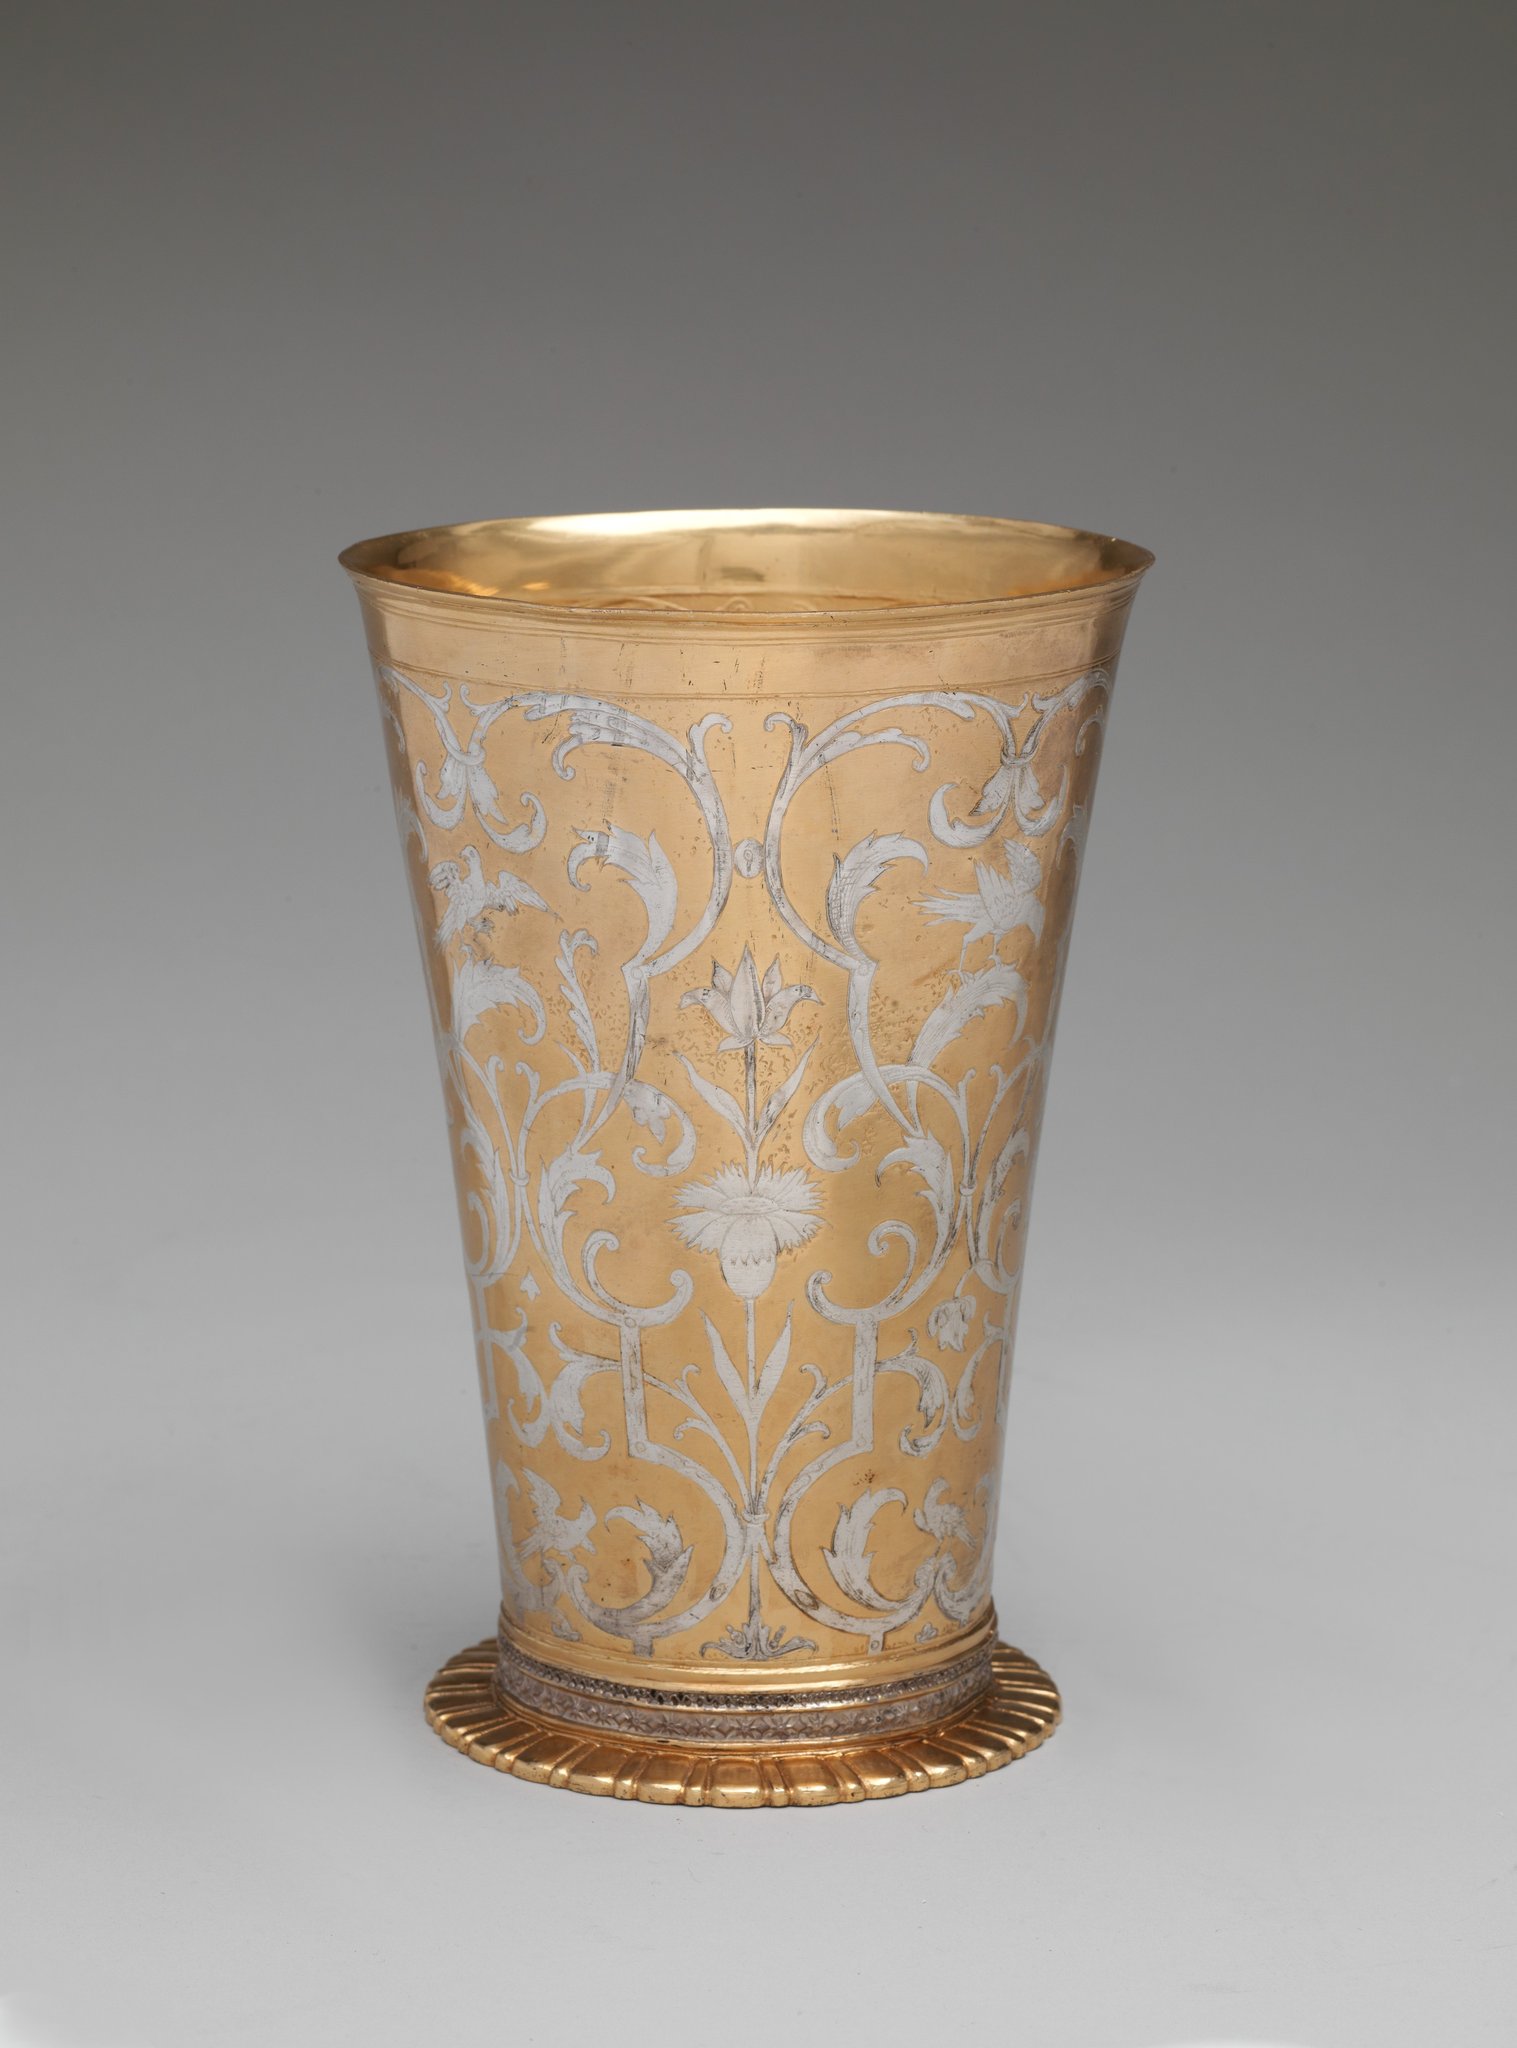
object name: beaker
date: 1801-1900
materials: metal, silver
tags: birds